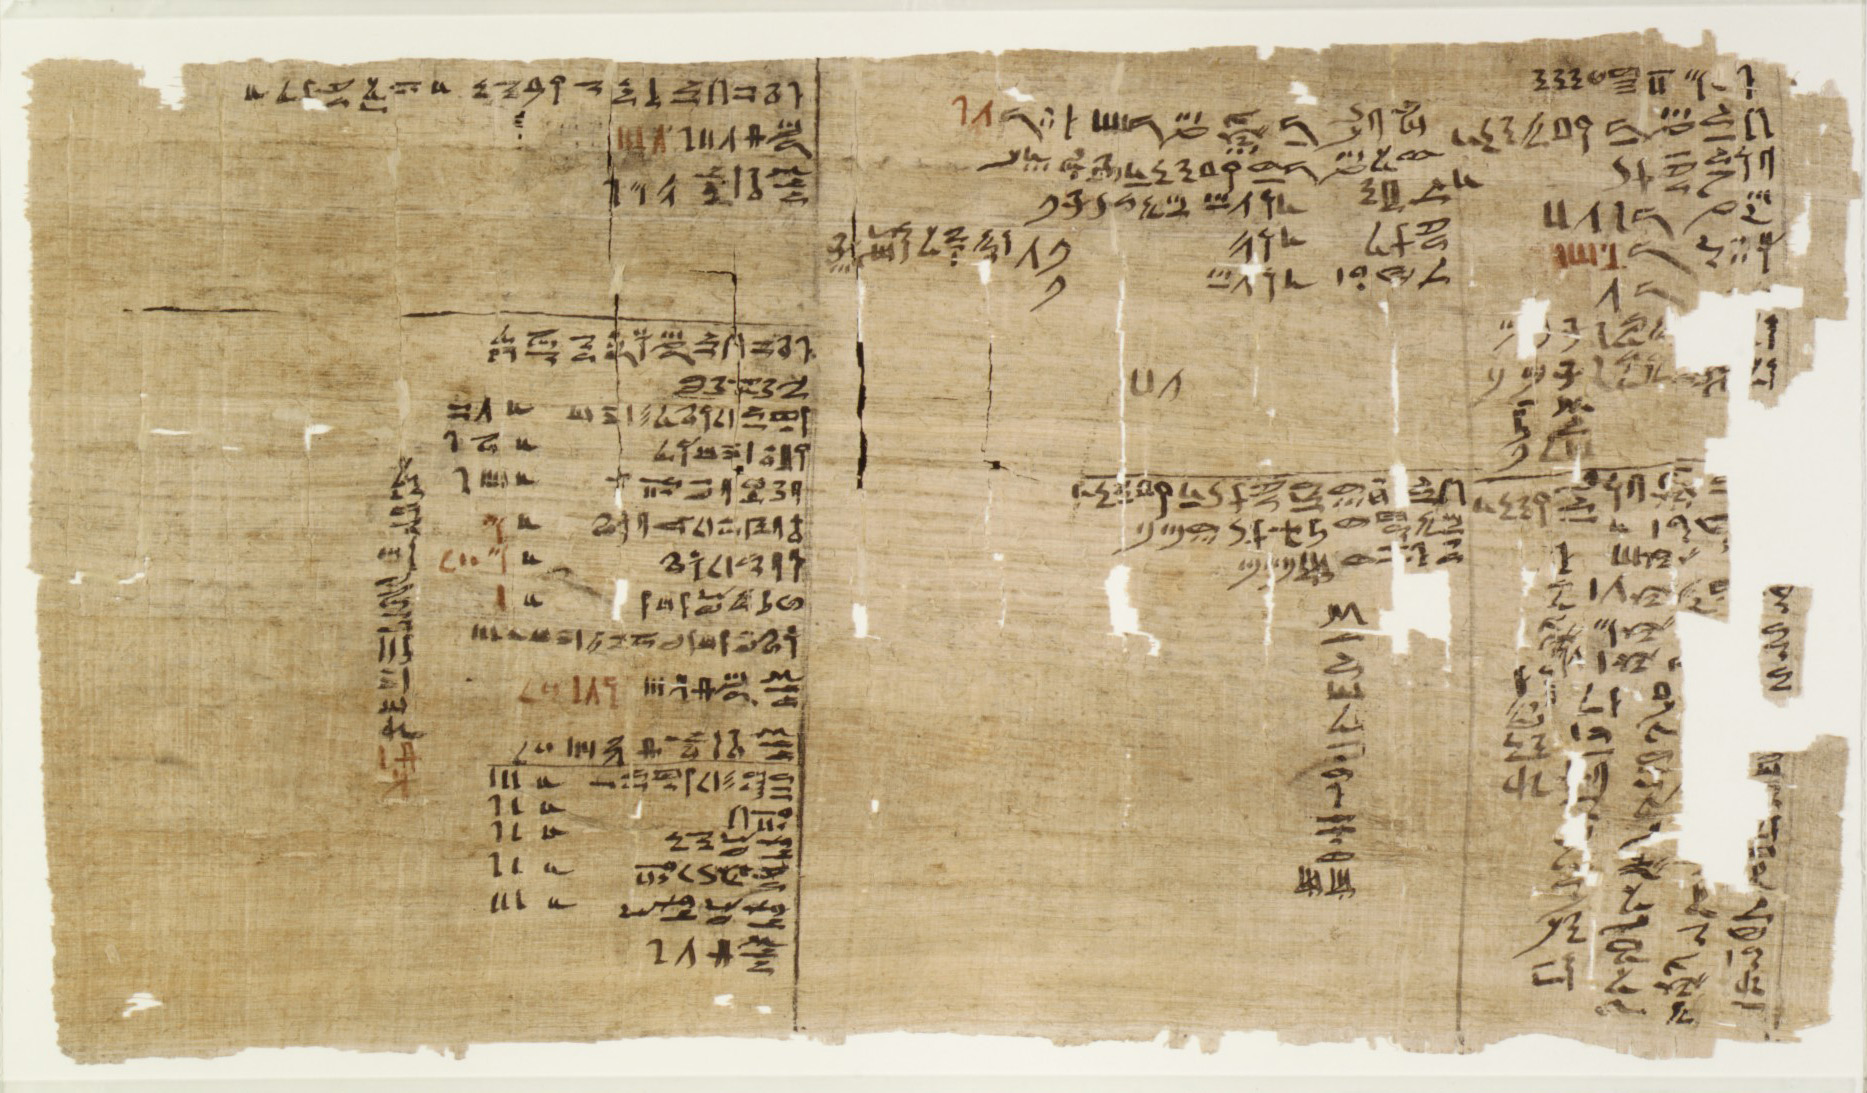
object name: papyrus, letter, heqanakht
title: Heqanakht Letter V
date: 1961-1917 BCE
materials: ink, papyrus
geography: egypt